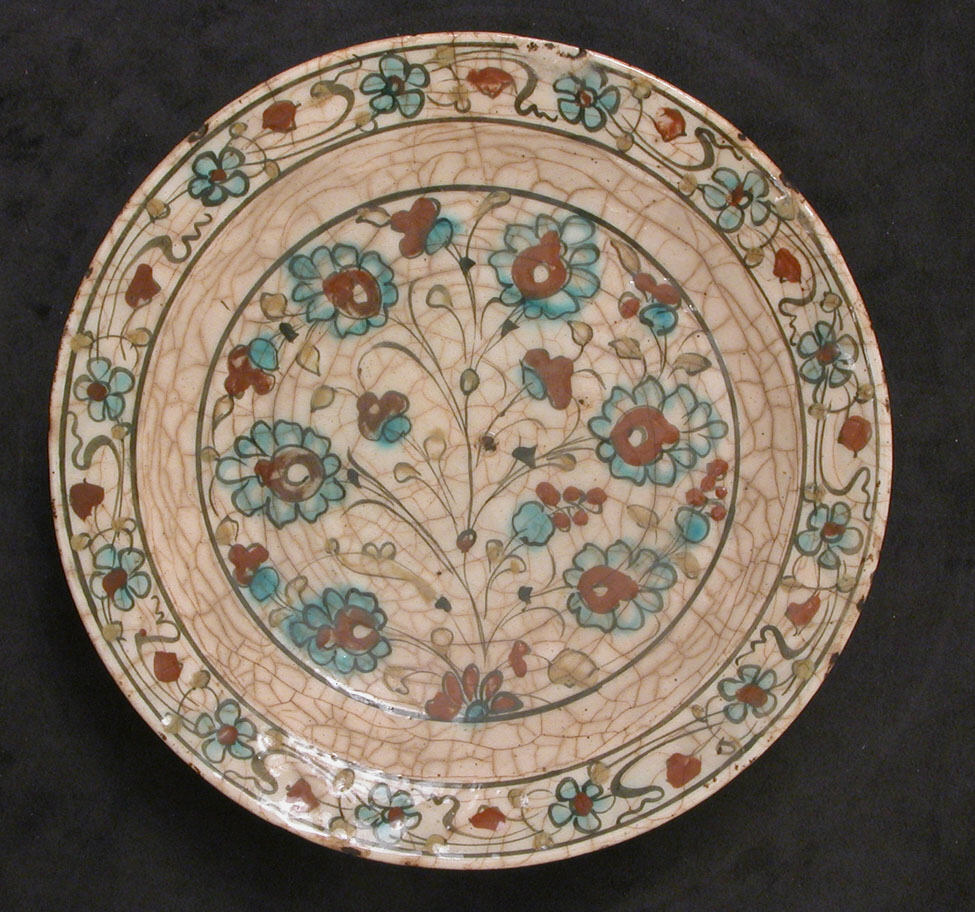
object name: dish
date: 1601-1700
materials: stonepaste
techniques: painting, underglaze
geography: iran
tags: flowers